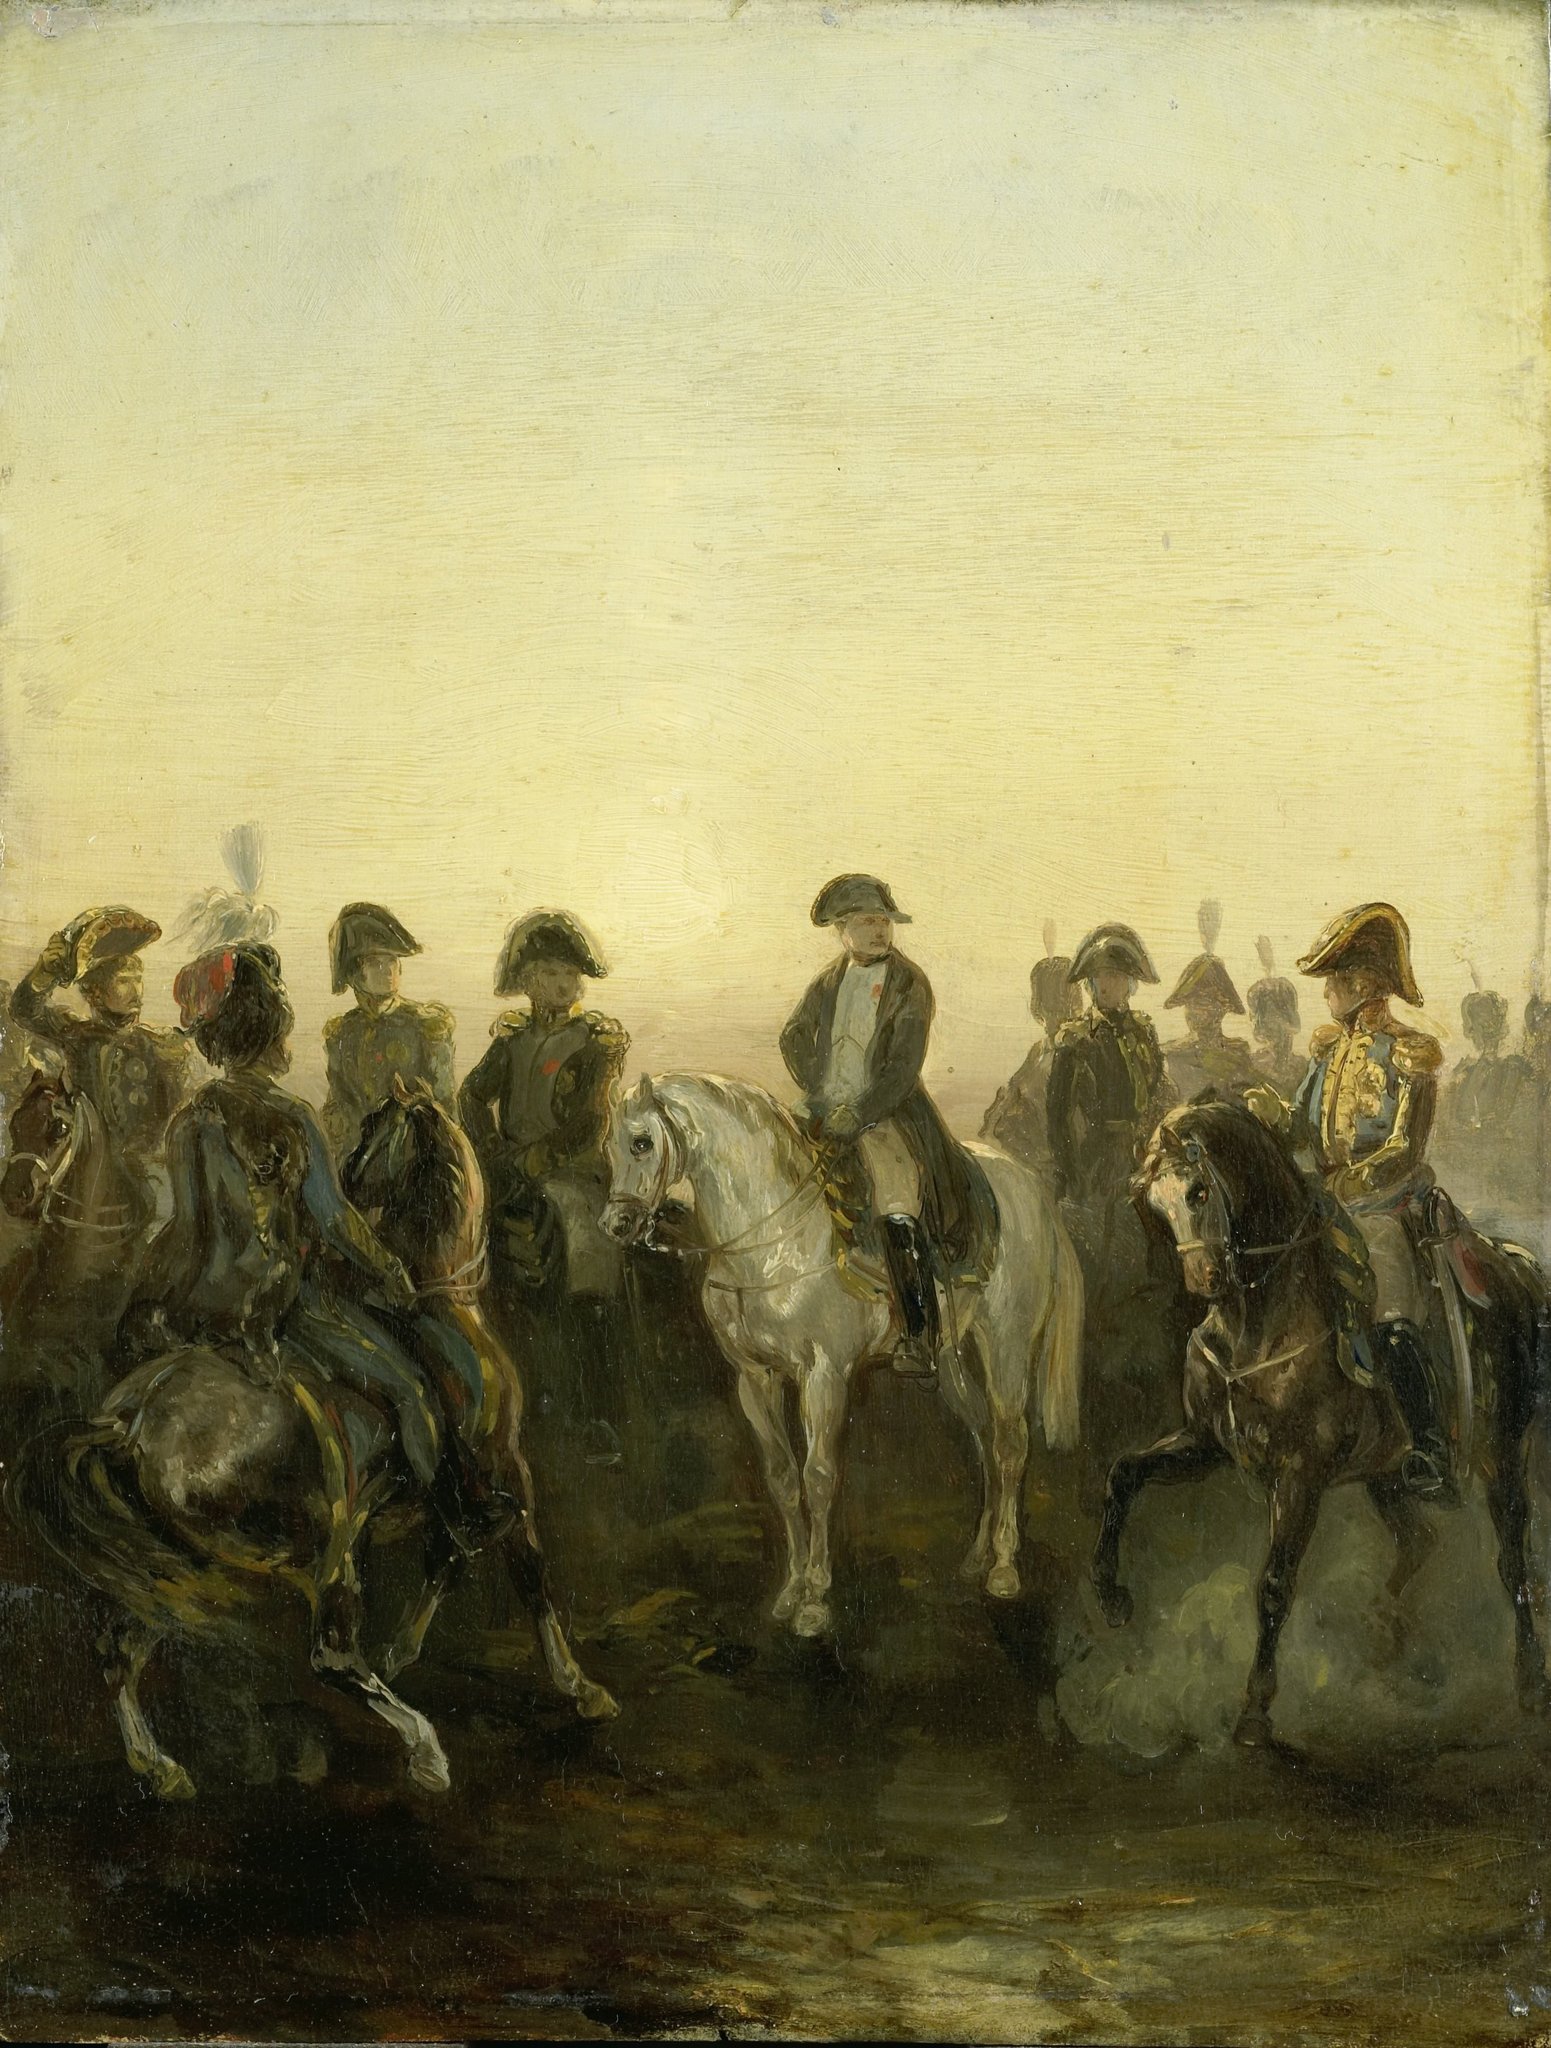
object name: painting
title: Napoleon with his Staff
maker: charles rochussen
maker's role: draughtsman, painter, print maker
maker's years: 1814-1894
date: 1840-1850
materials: oil, panel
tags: napoleon i (emperor of the french), riding a horse, ass, or mule; rider, horseman, commander-in-chief, general, marshal, historical persons, battle (+ land forces)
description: Napoleon met zijn staf. Napoleon gezeten op een schimmel, omringd door zijn officieren te paard.